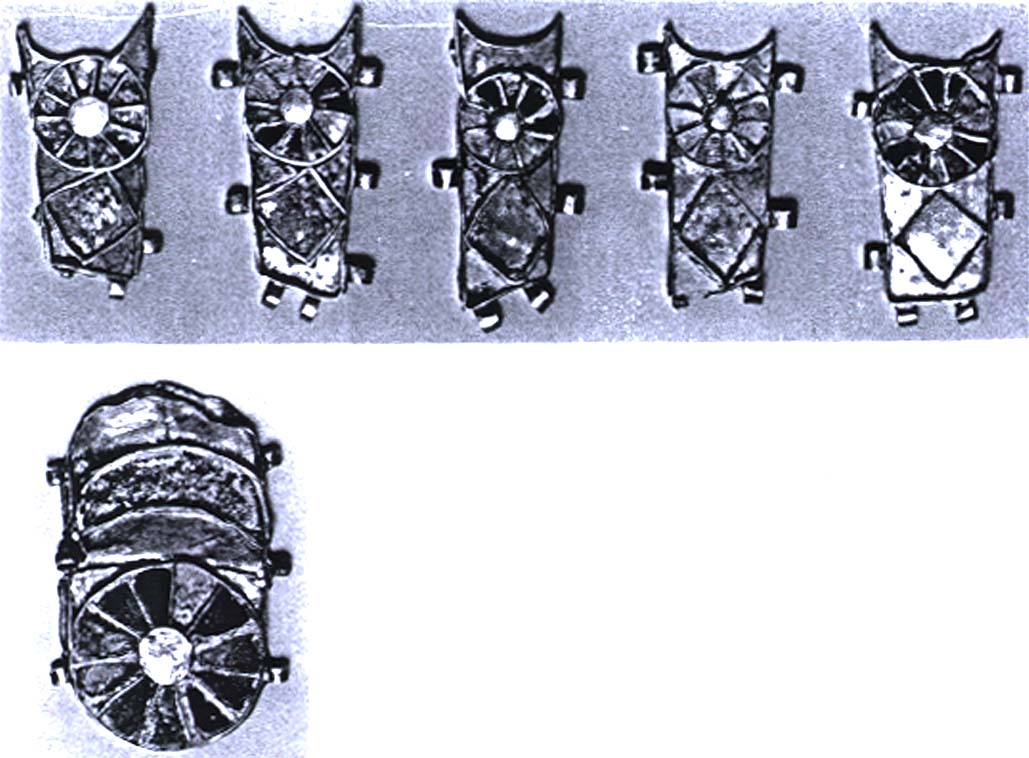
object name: group of jewelry element 6 rosette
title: 6 rosettes: 1 terminal; 5 trapezoids; see 26.8.117a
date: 1479-1425 BCE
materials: gemstone, glass, gold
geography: egypt